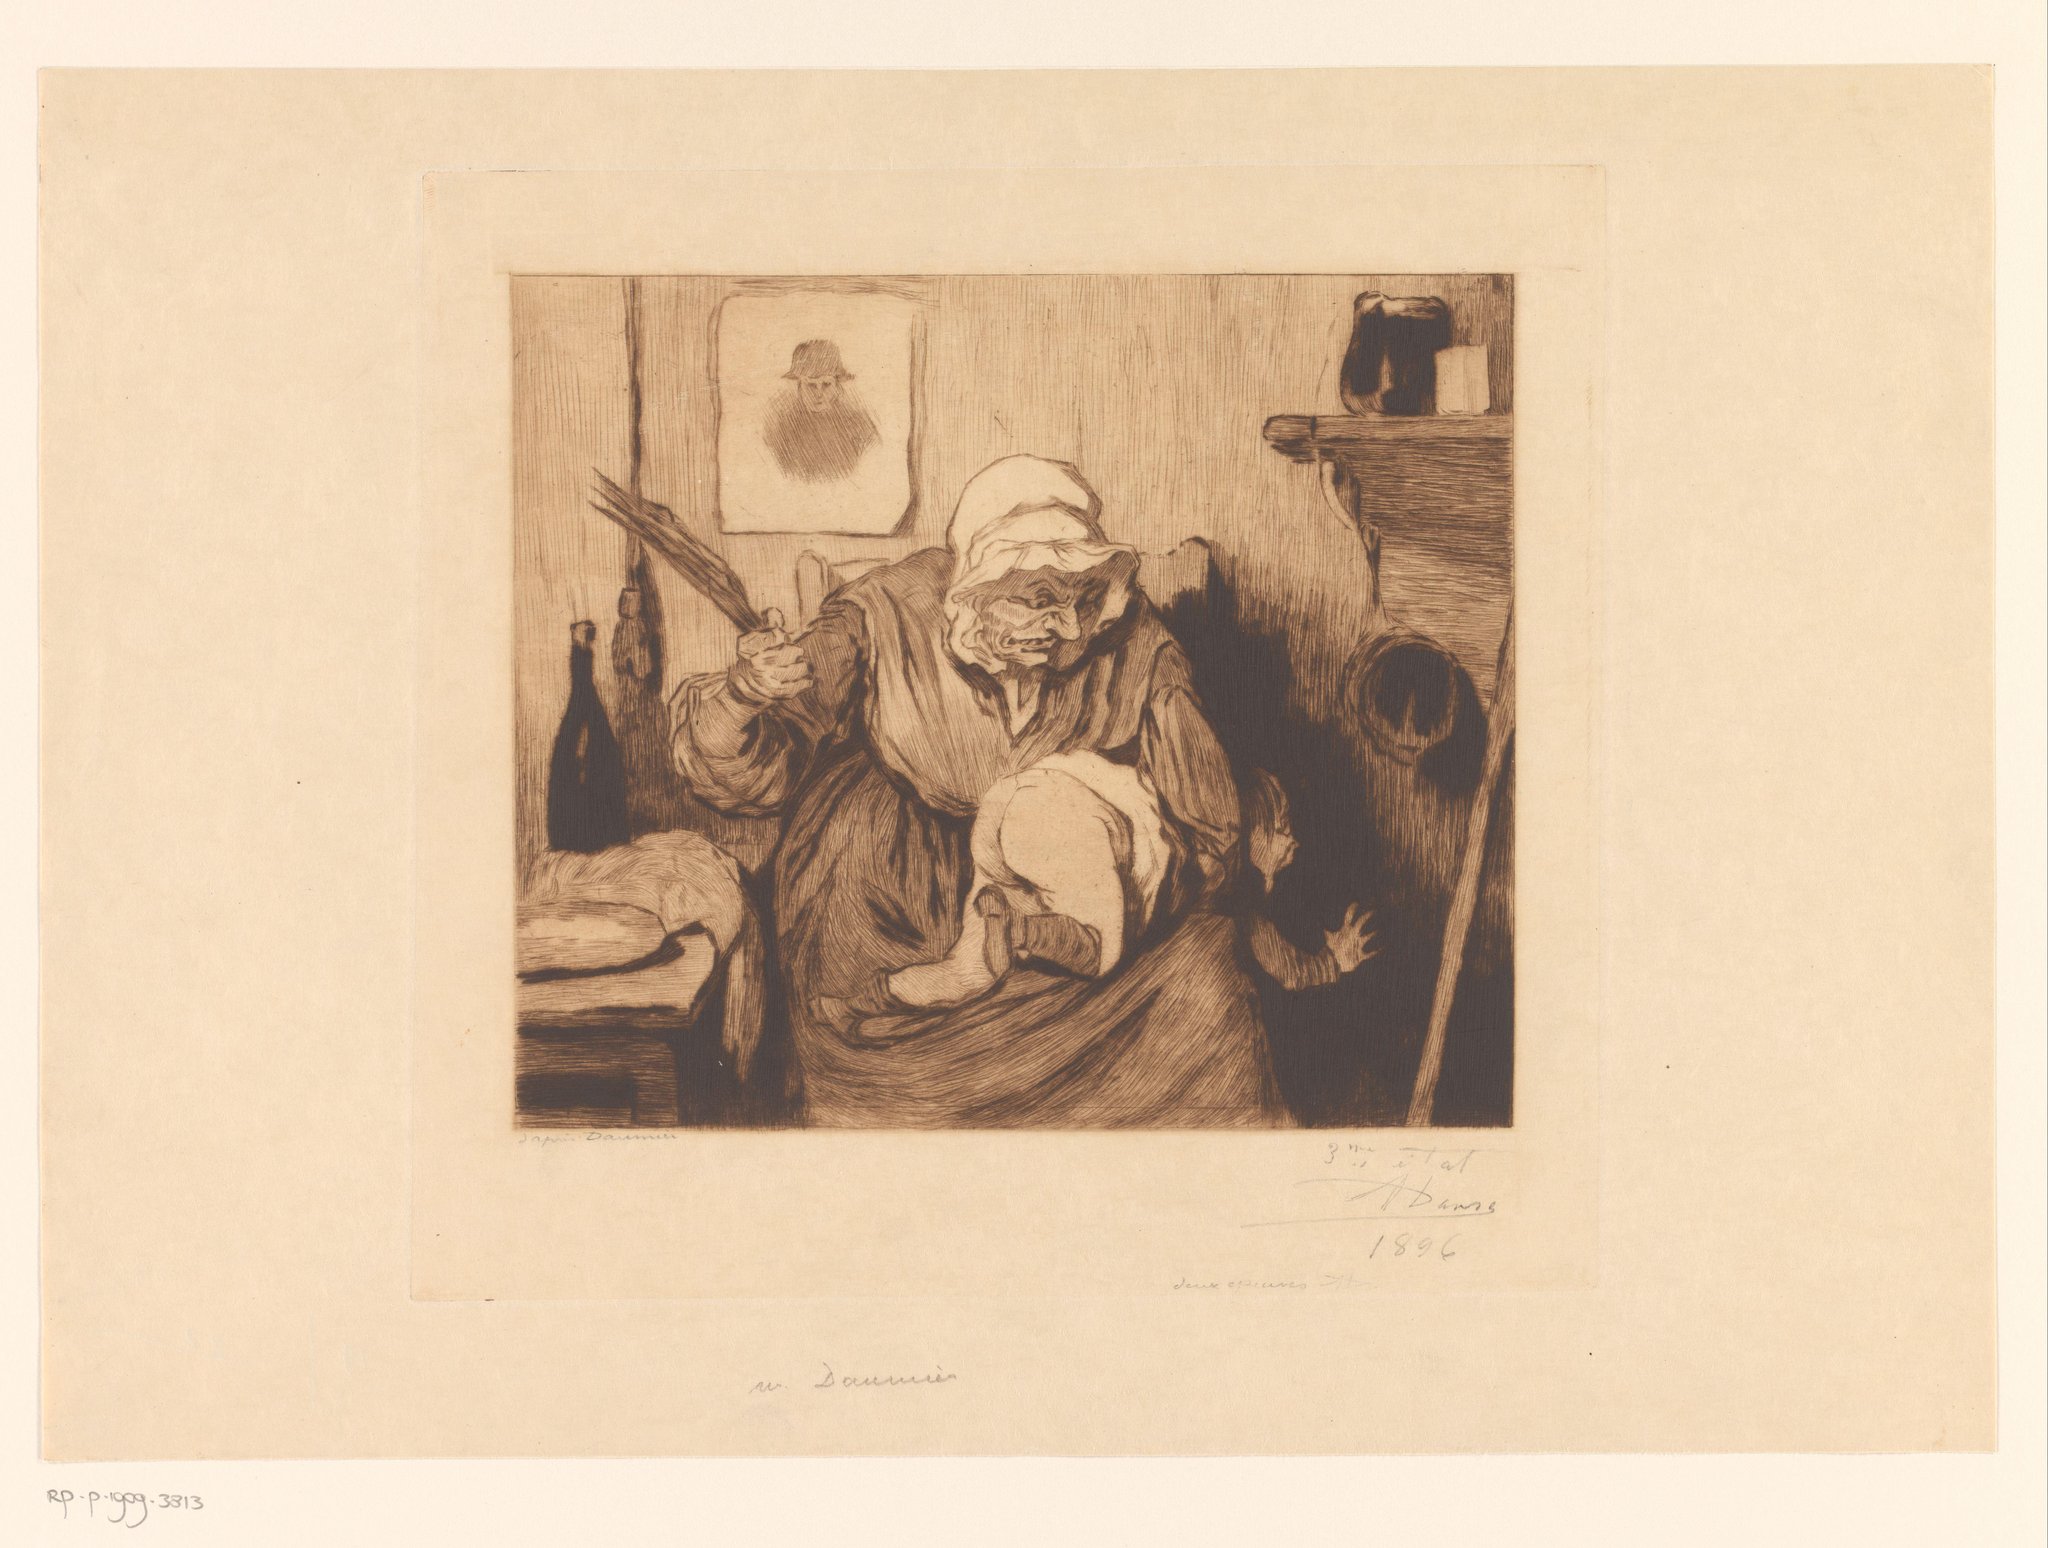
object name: print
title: Kind krijgt billenkoek van een oude vrouw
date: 1896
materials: paper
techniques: drypoint, etching, intaglio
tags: feeling (one of the five senses), spanking, drubbing (of naughty children)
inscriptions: annotation: ‘3me état;deux epreuves’, collector's mark: Lugt 2228